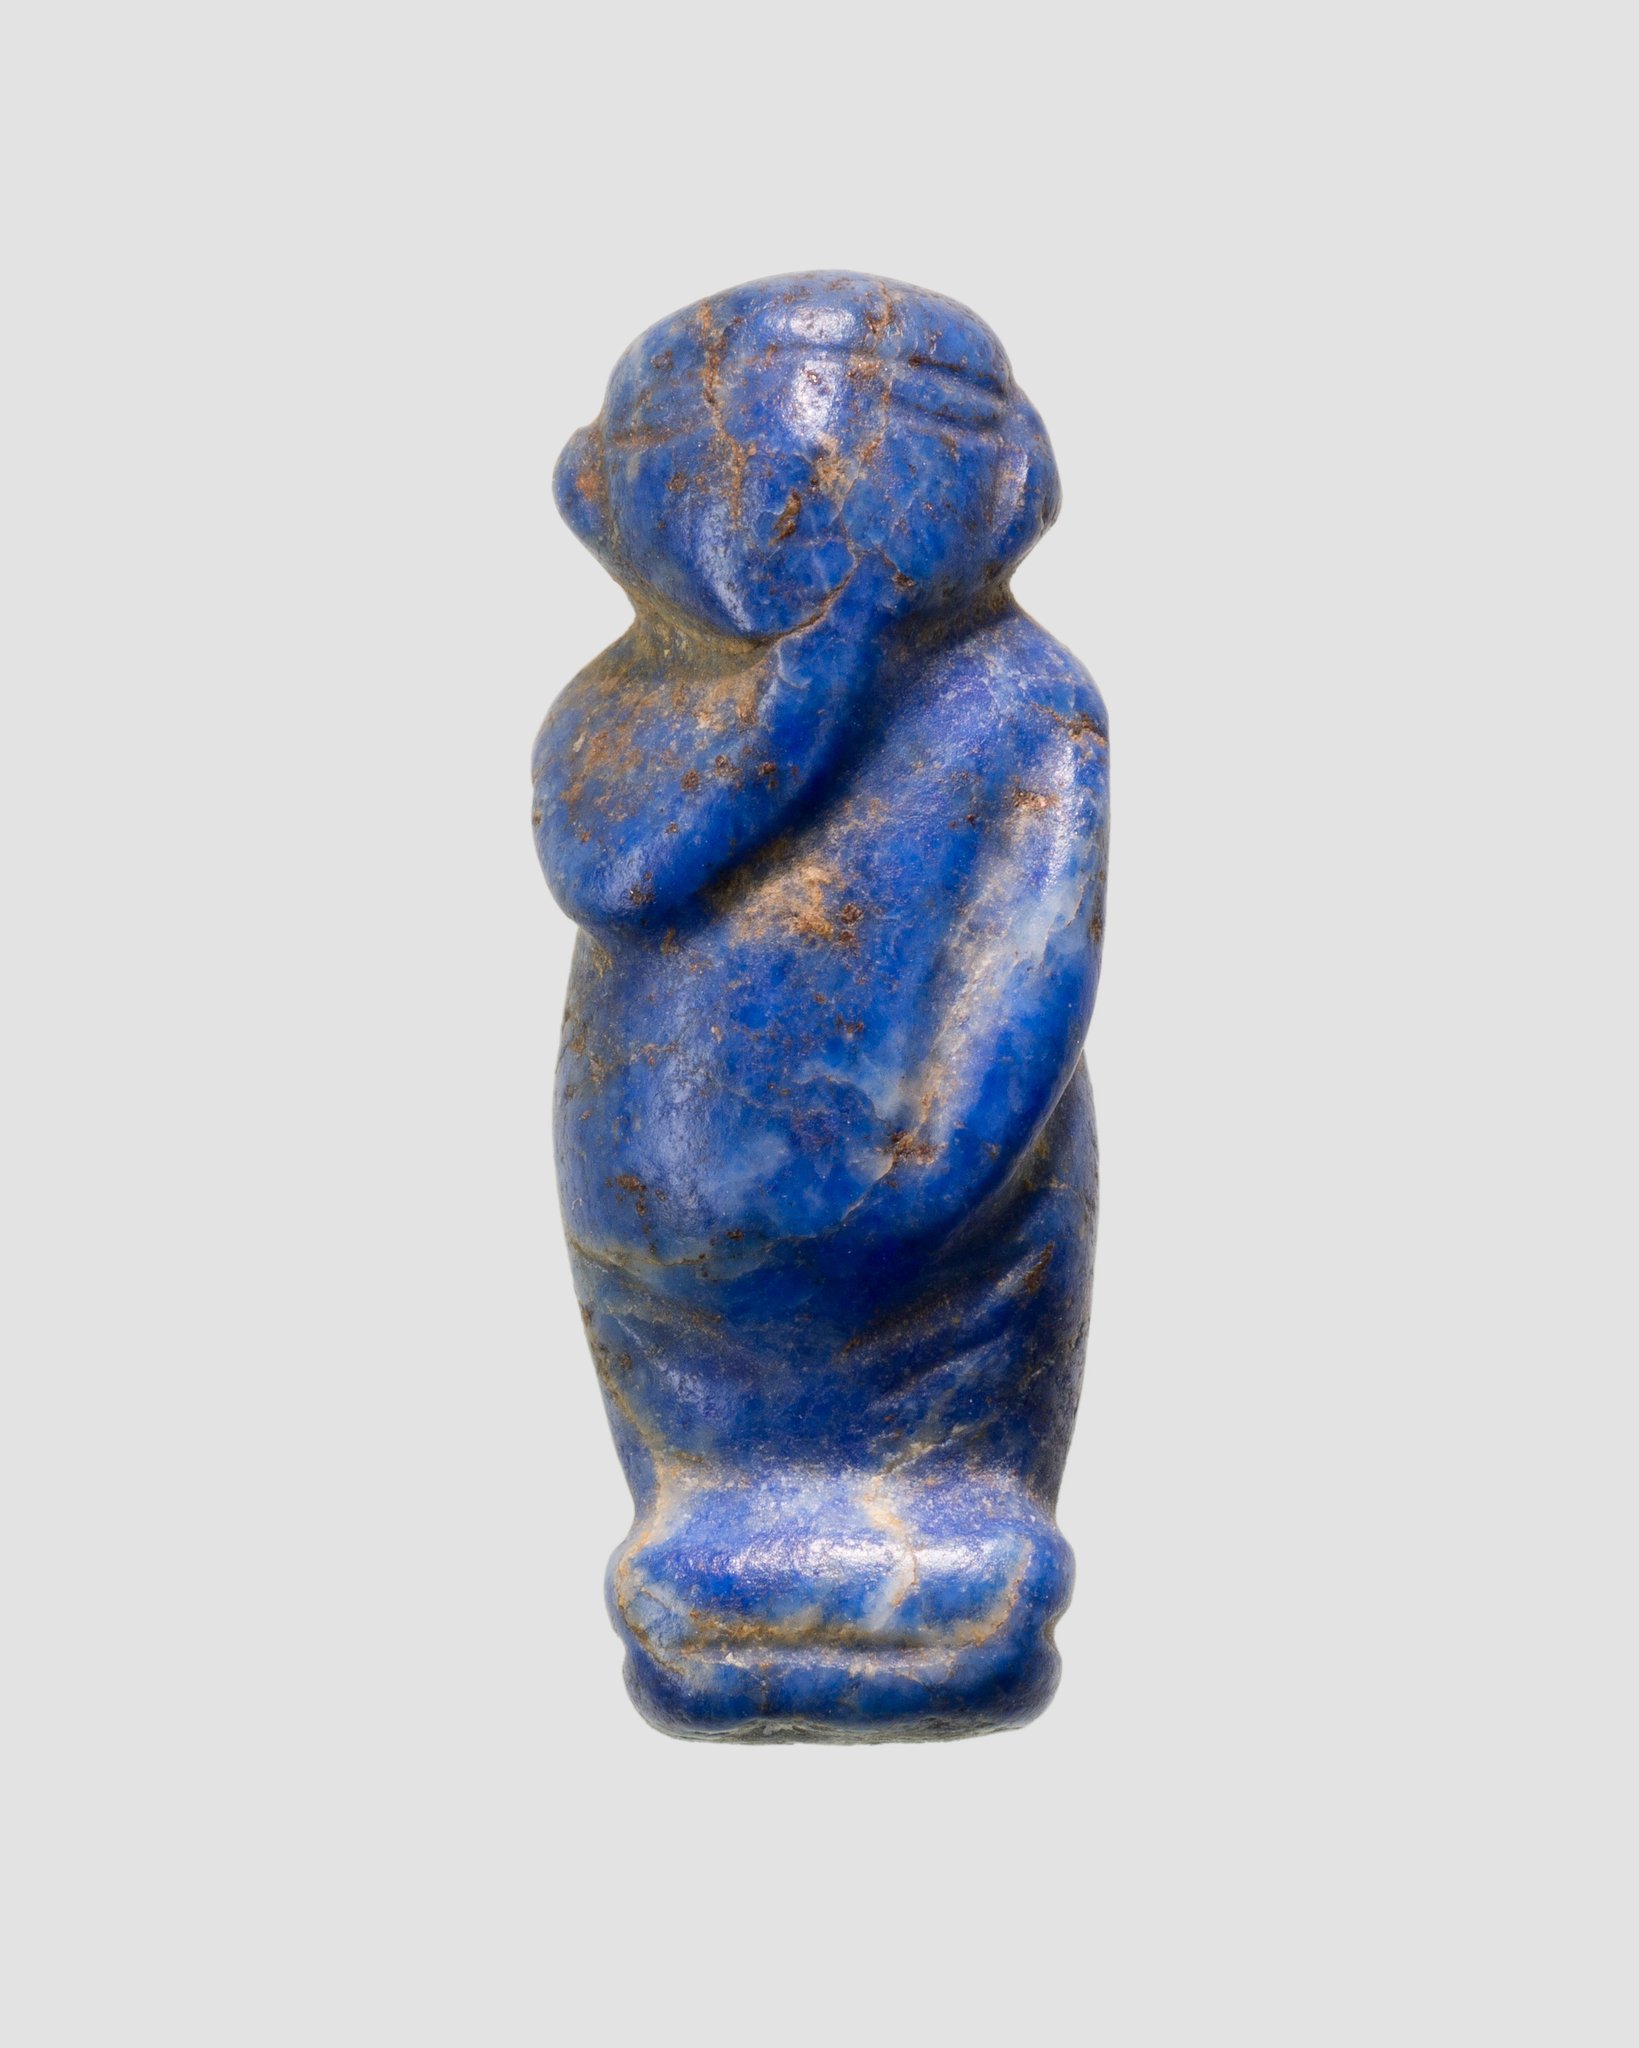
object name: amulet, harpokrates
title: Amulet of Harpokrates ?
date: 1850-1640 BCE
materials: lapis lazuli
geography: egypt